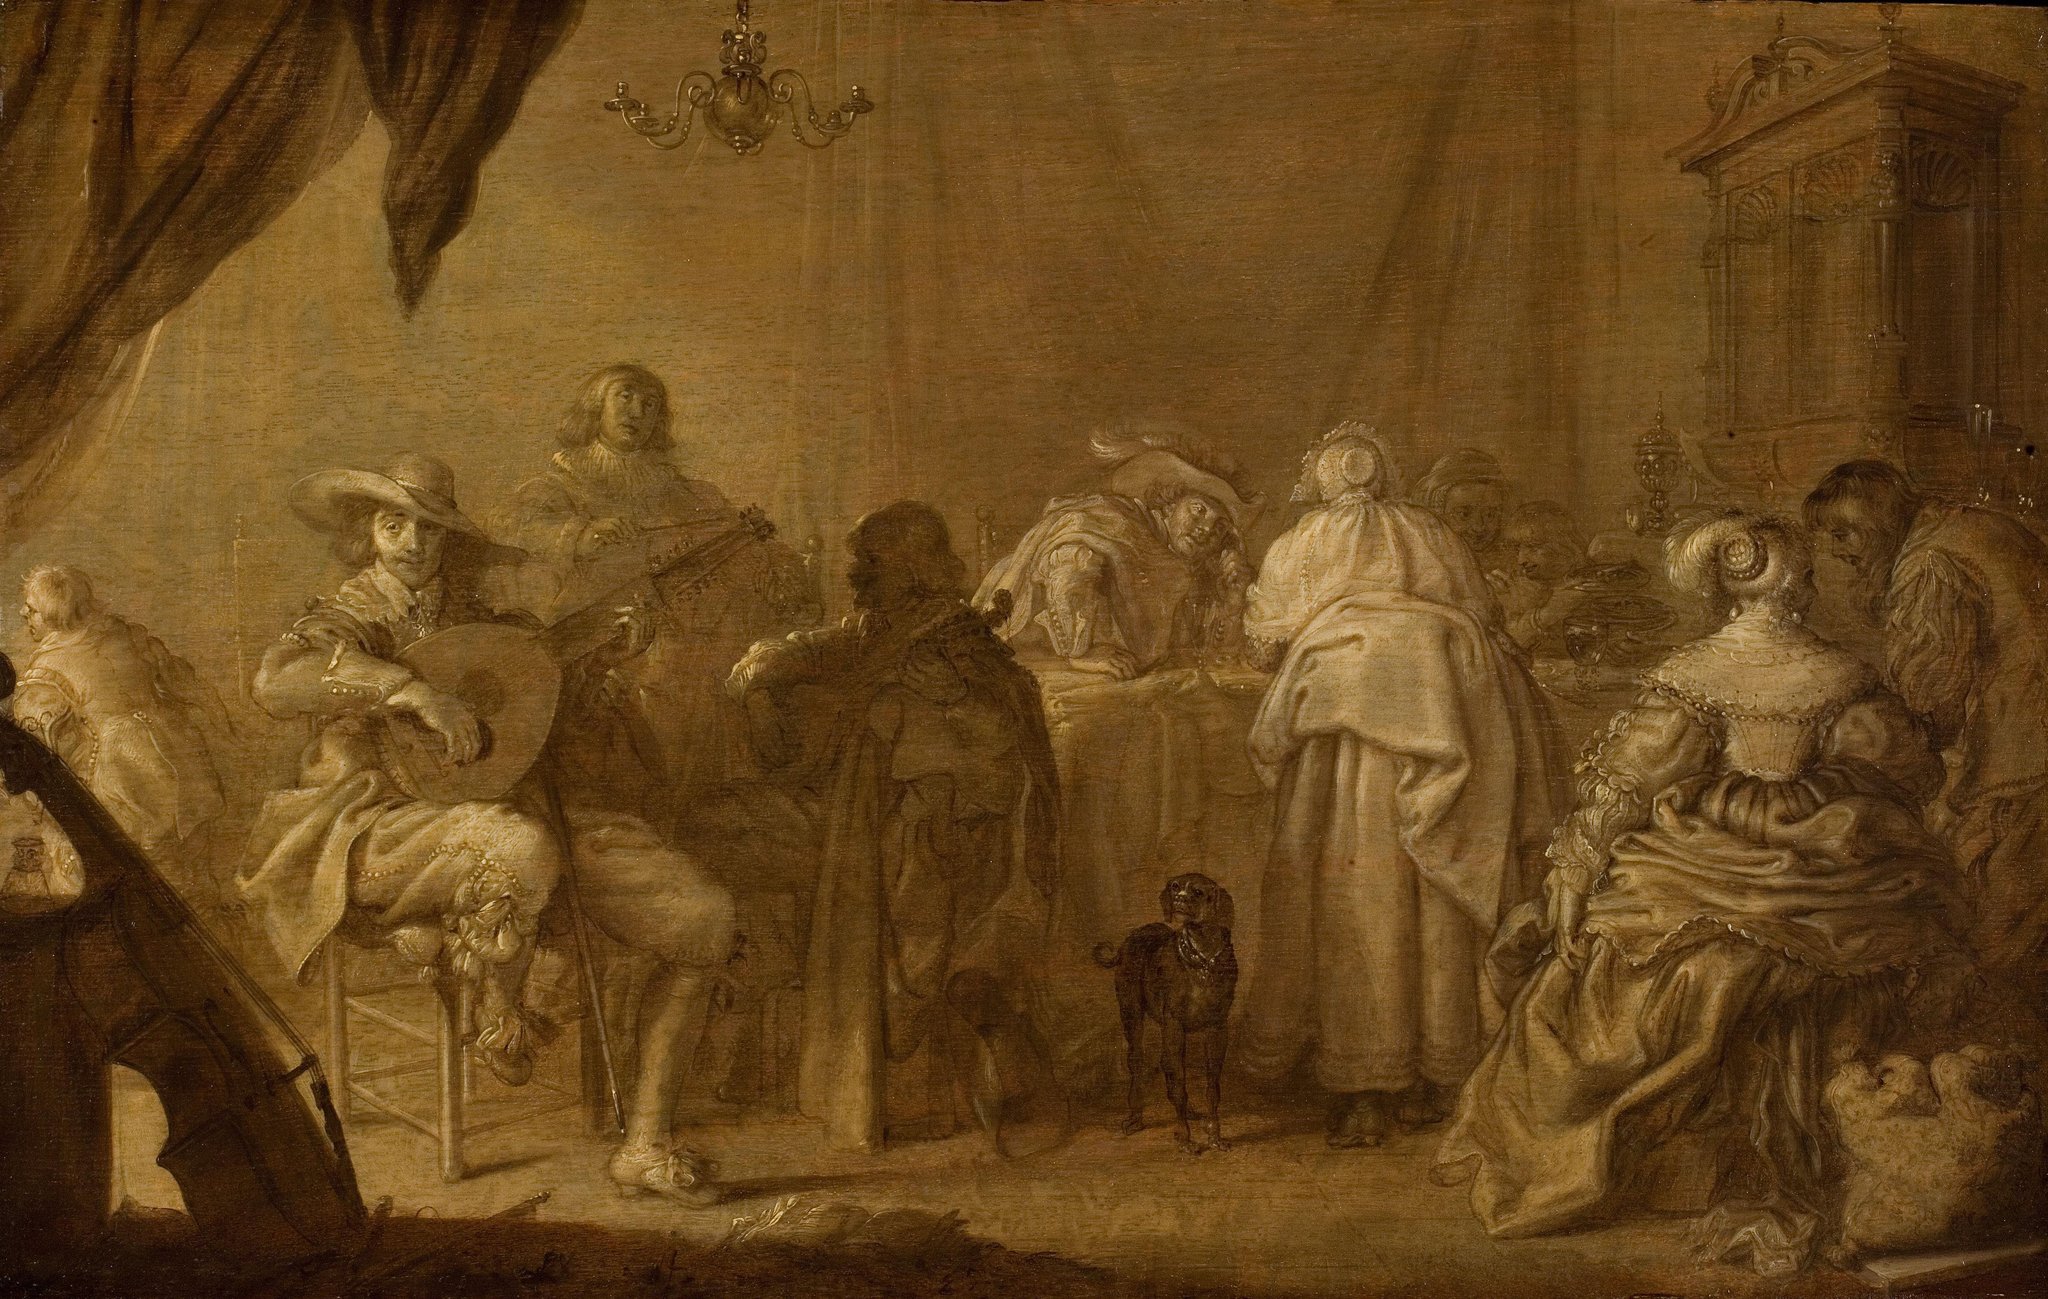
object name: grisaille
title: A Musical Party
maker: adriaen pietersz van de venne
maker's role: draughtsman, painter, print maker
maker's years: 1589-1662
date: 1635-1645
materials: oil, panel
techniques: grisaille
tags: banquet of elegant company, more than one musician with instrument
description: Interieur met een musicerend gezelschap aan een gedekte tafel. Links een man met een luit, een vioolspeler en een man met een cister, tegen een tafel staat een cello geleund. Aan tafel verder enkele heren en dames, op de voorgrond staat een hond.